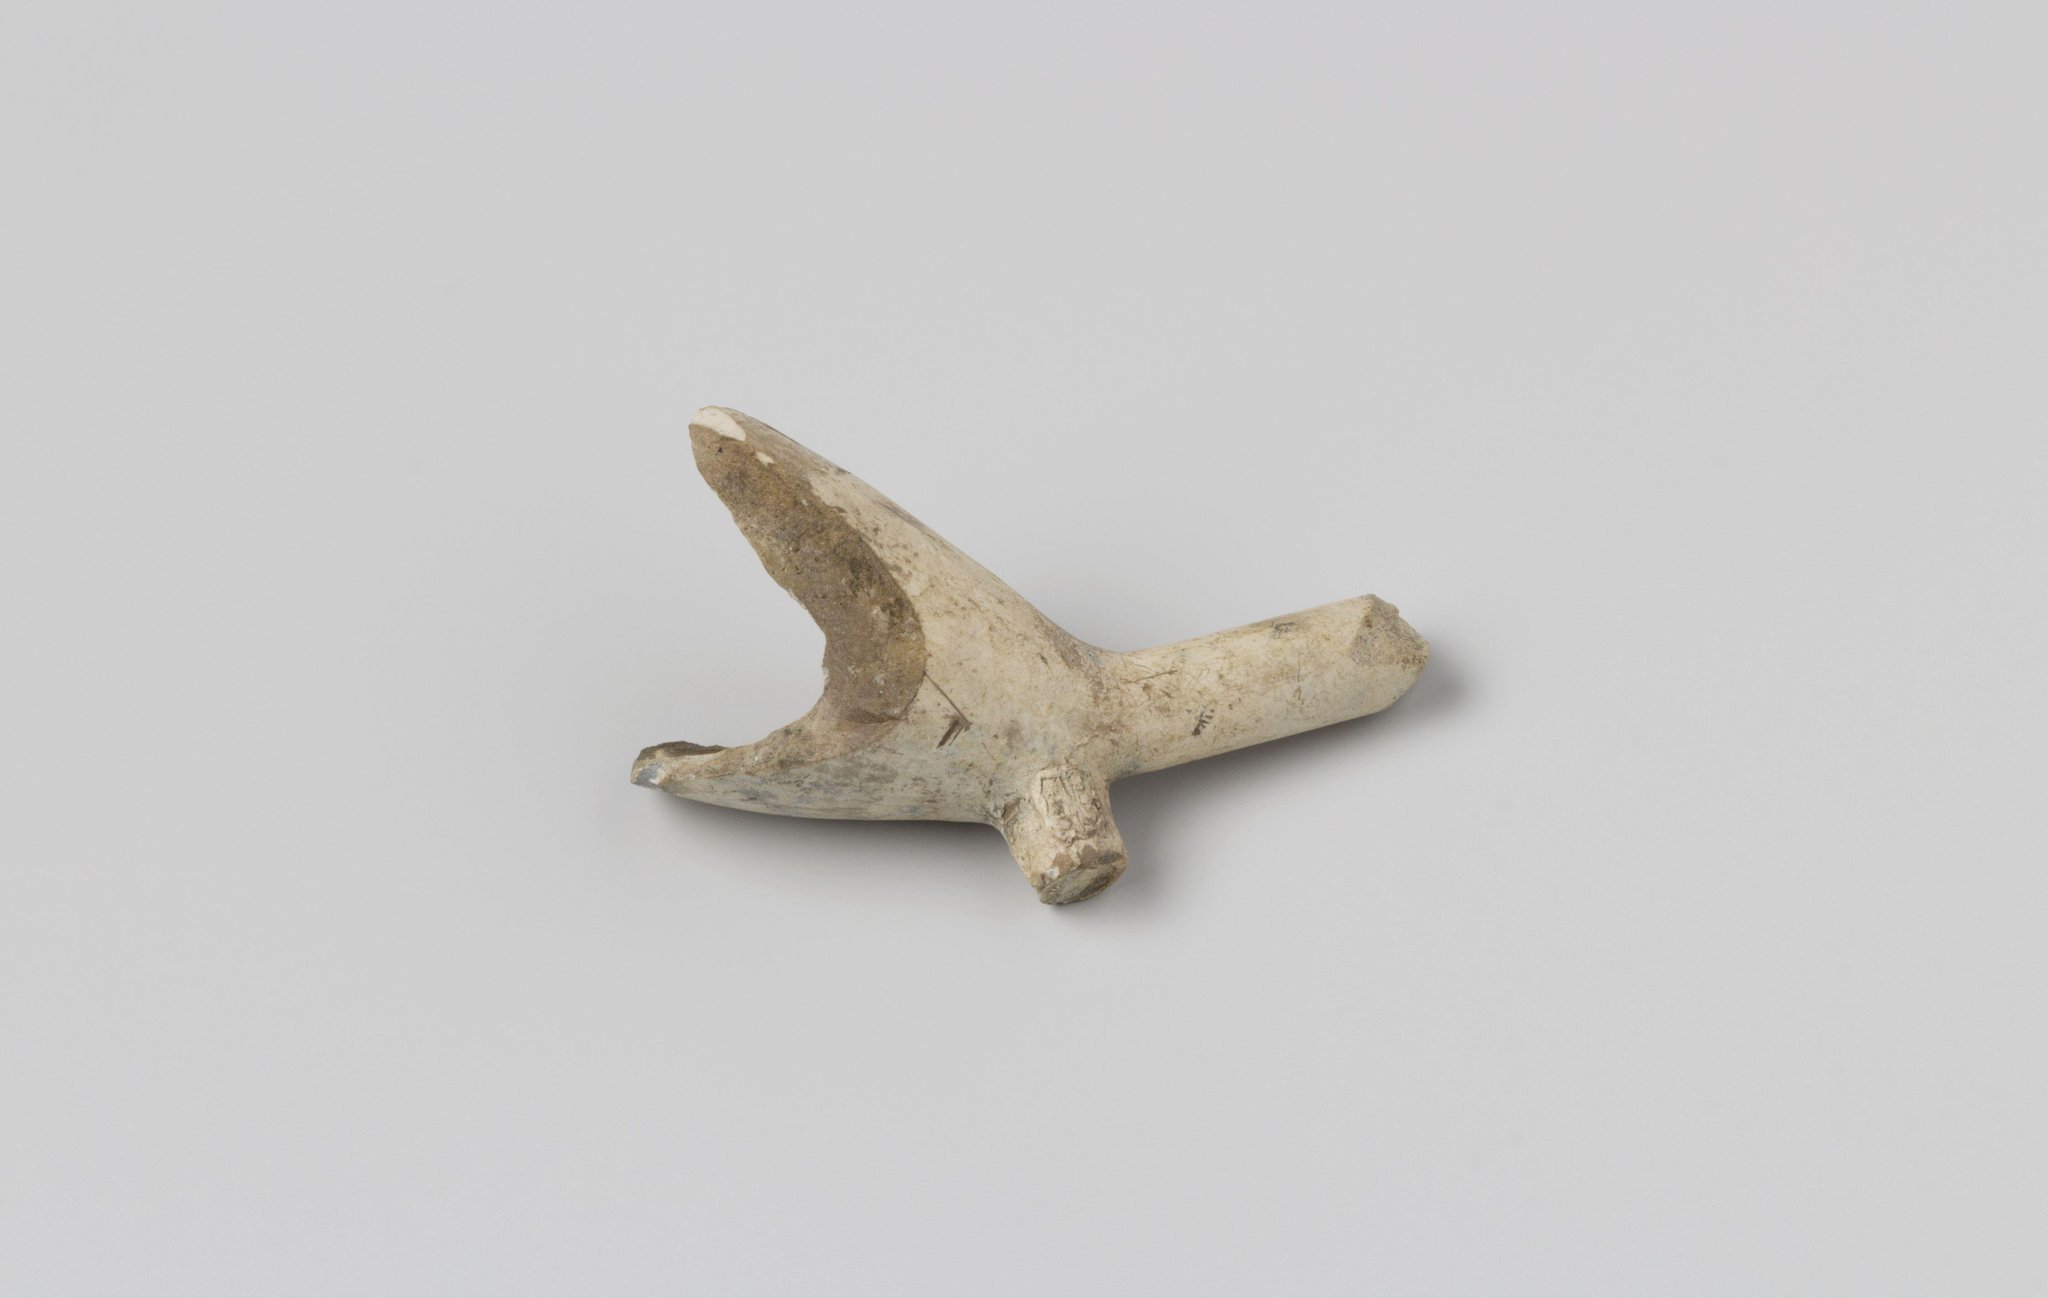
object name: pipe bowl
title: Fragment pijpenkop uit het wrak van de Oost-Indiëvaarder Hollandia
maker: Anonymous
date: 1700-1743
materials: clay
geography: netherlands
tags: verenigde oostindische compagnie, hollandia (schip), annet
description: Pipe, bowl, heelmark: fish, flounder; fragm, 1hsm1.